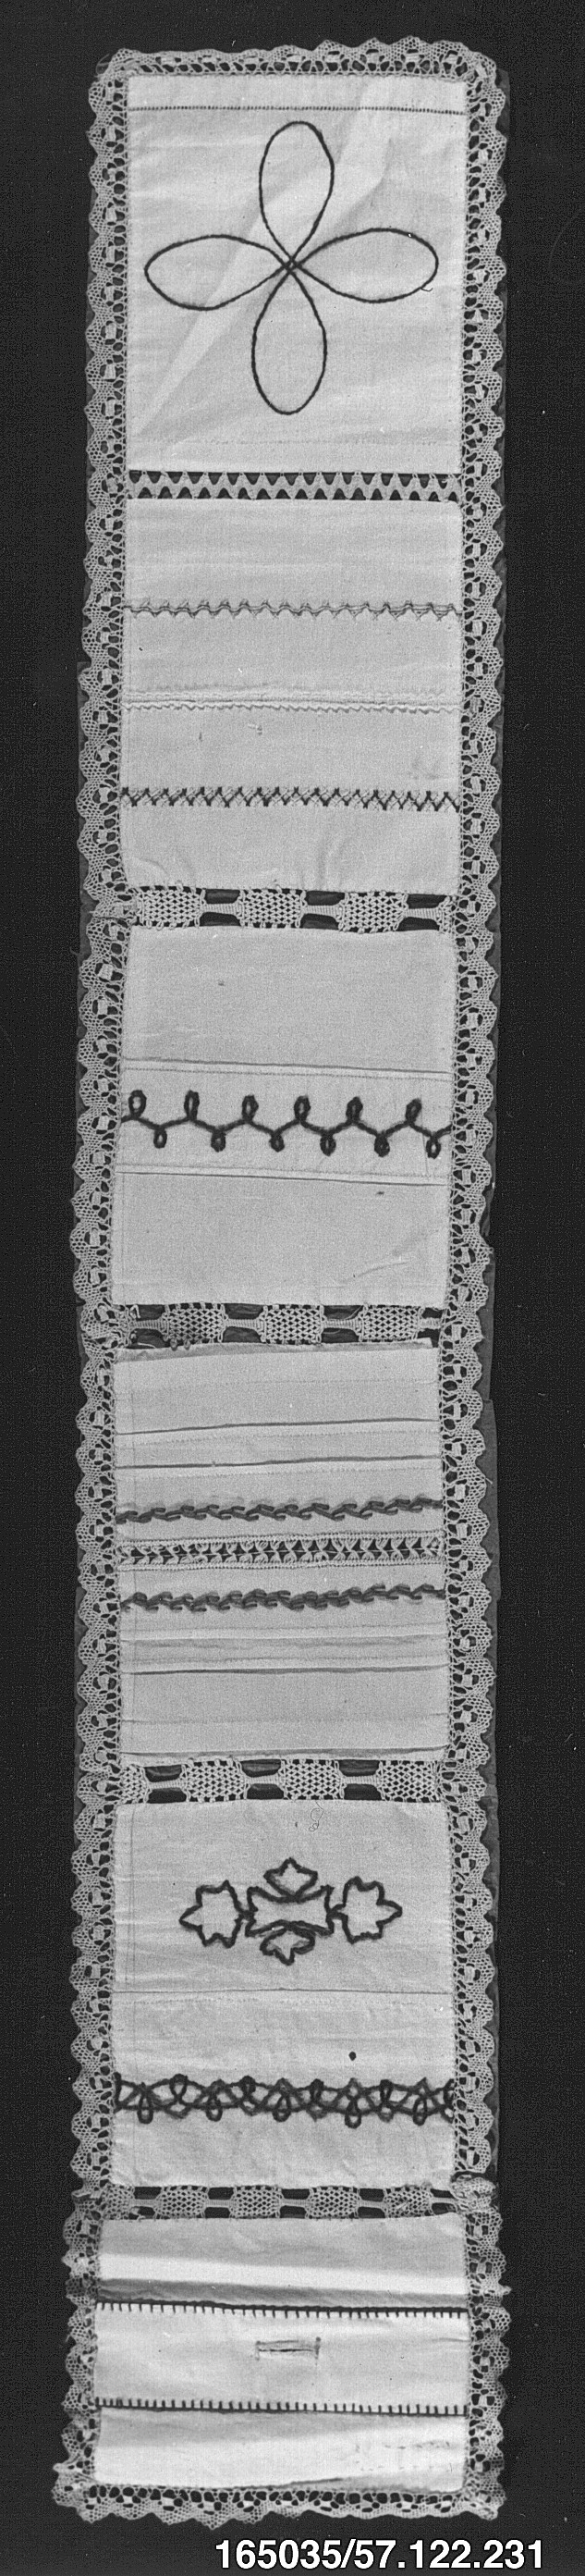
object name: sampler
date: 1801-1900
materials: cotton, linen, wool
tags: flowers